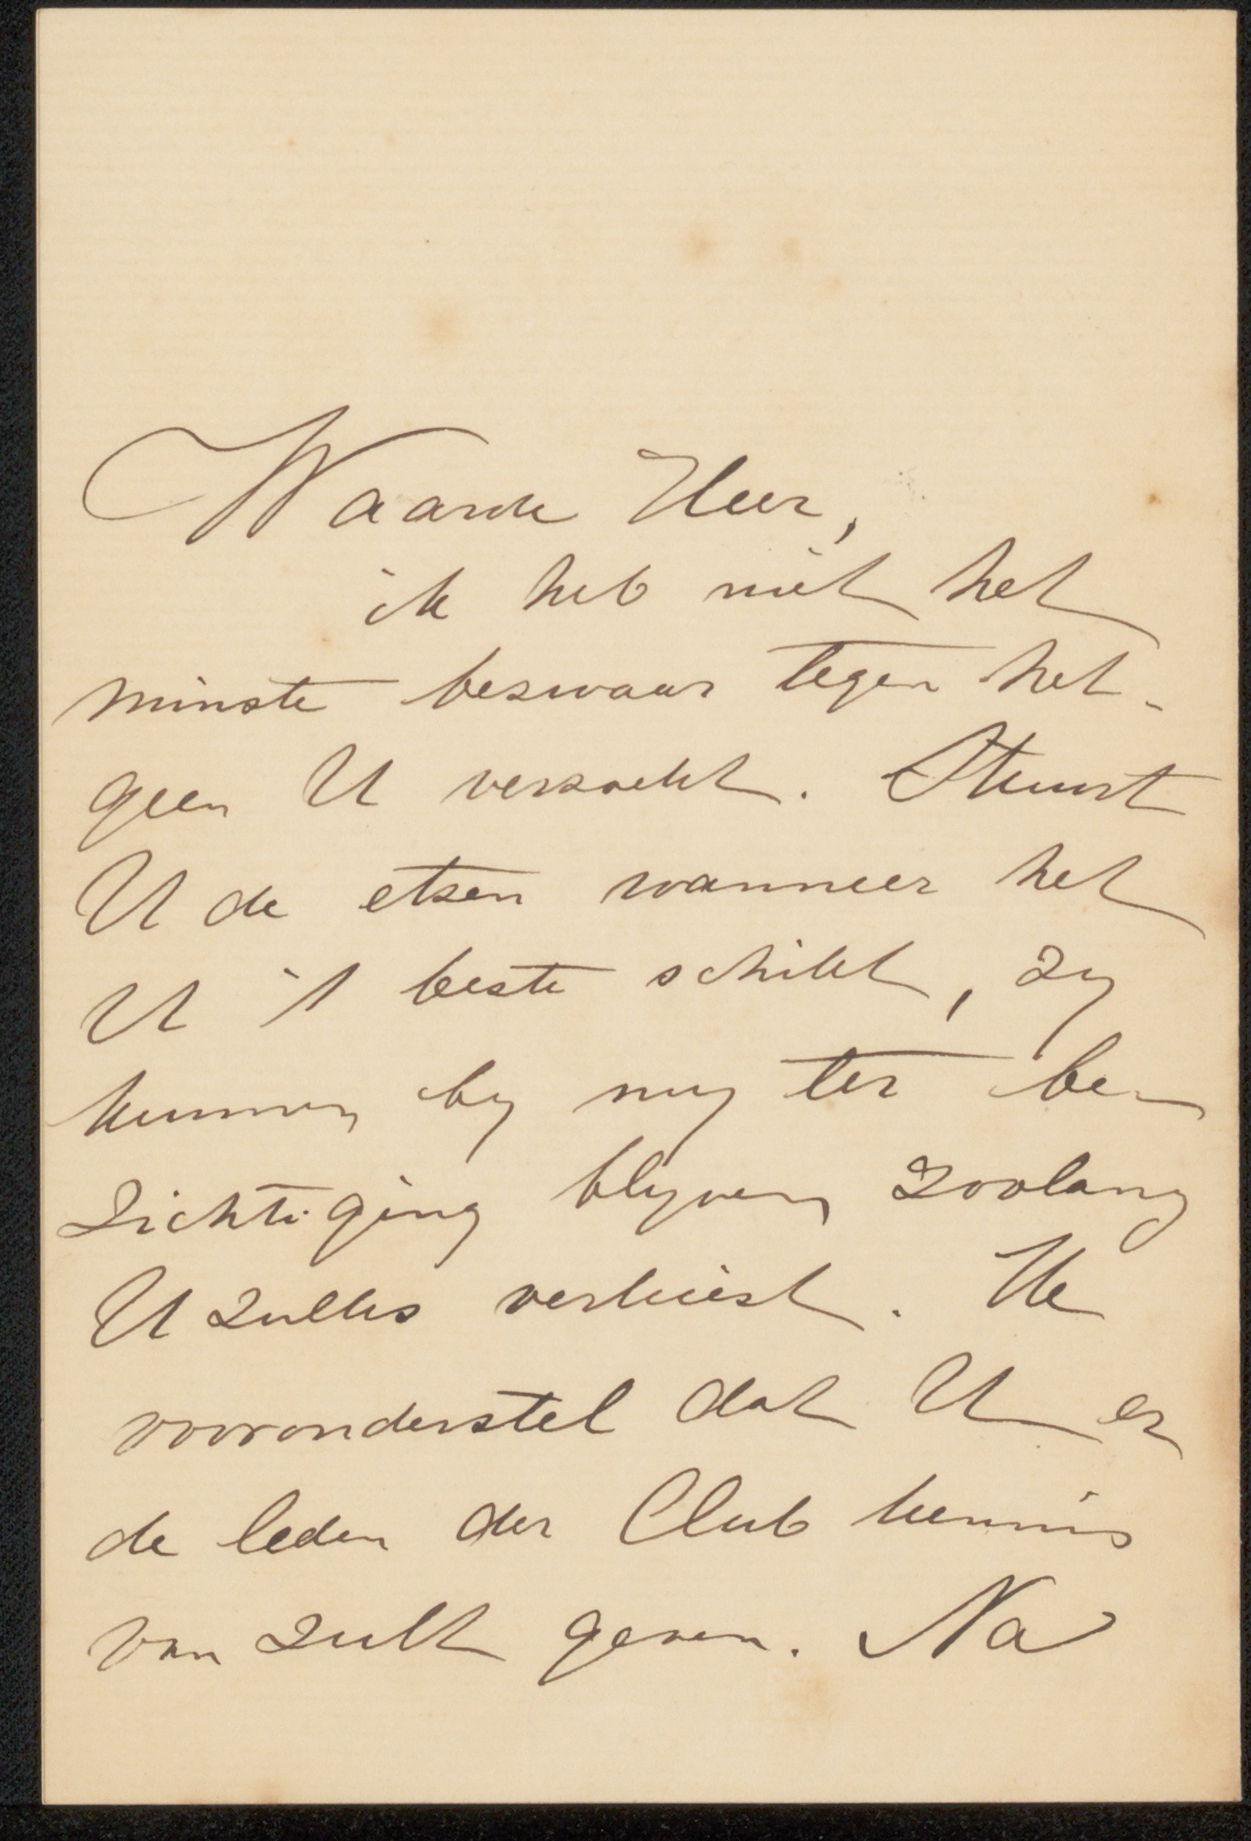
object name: letter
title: Brief aan Philip Zilcken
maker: wally moes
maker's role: draughtsman, print maker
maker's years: 1856-1918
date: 1866-1918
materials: ink, paper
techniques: pen, writing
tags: the hague, painter, draughtsman, philip zilcken, the graphic arts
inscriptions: watermark, collector's mark: ‘RPK’